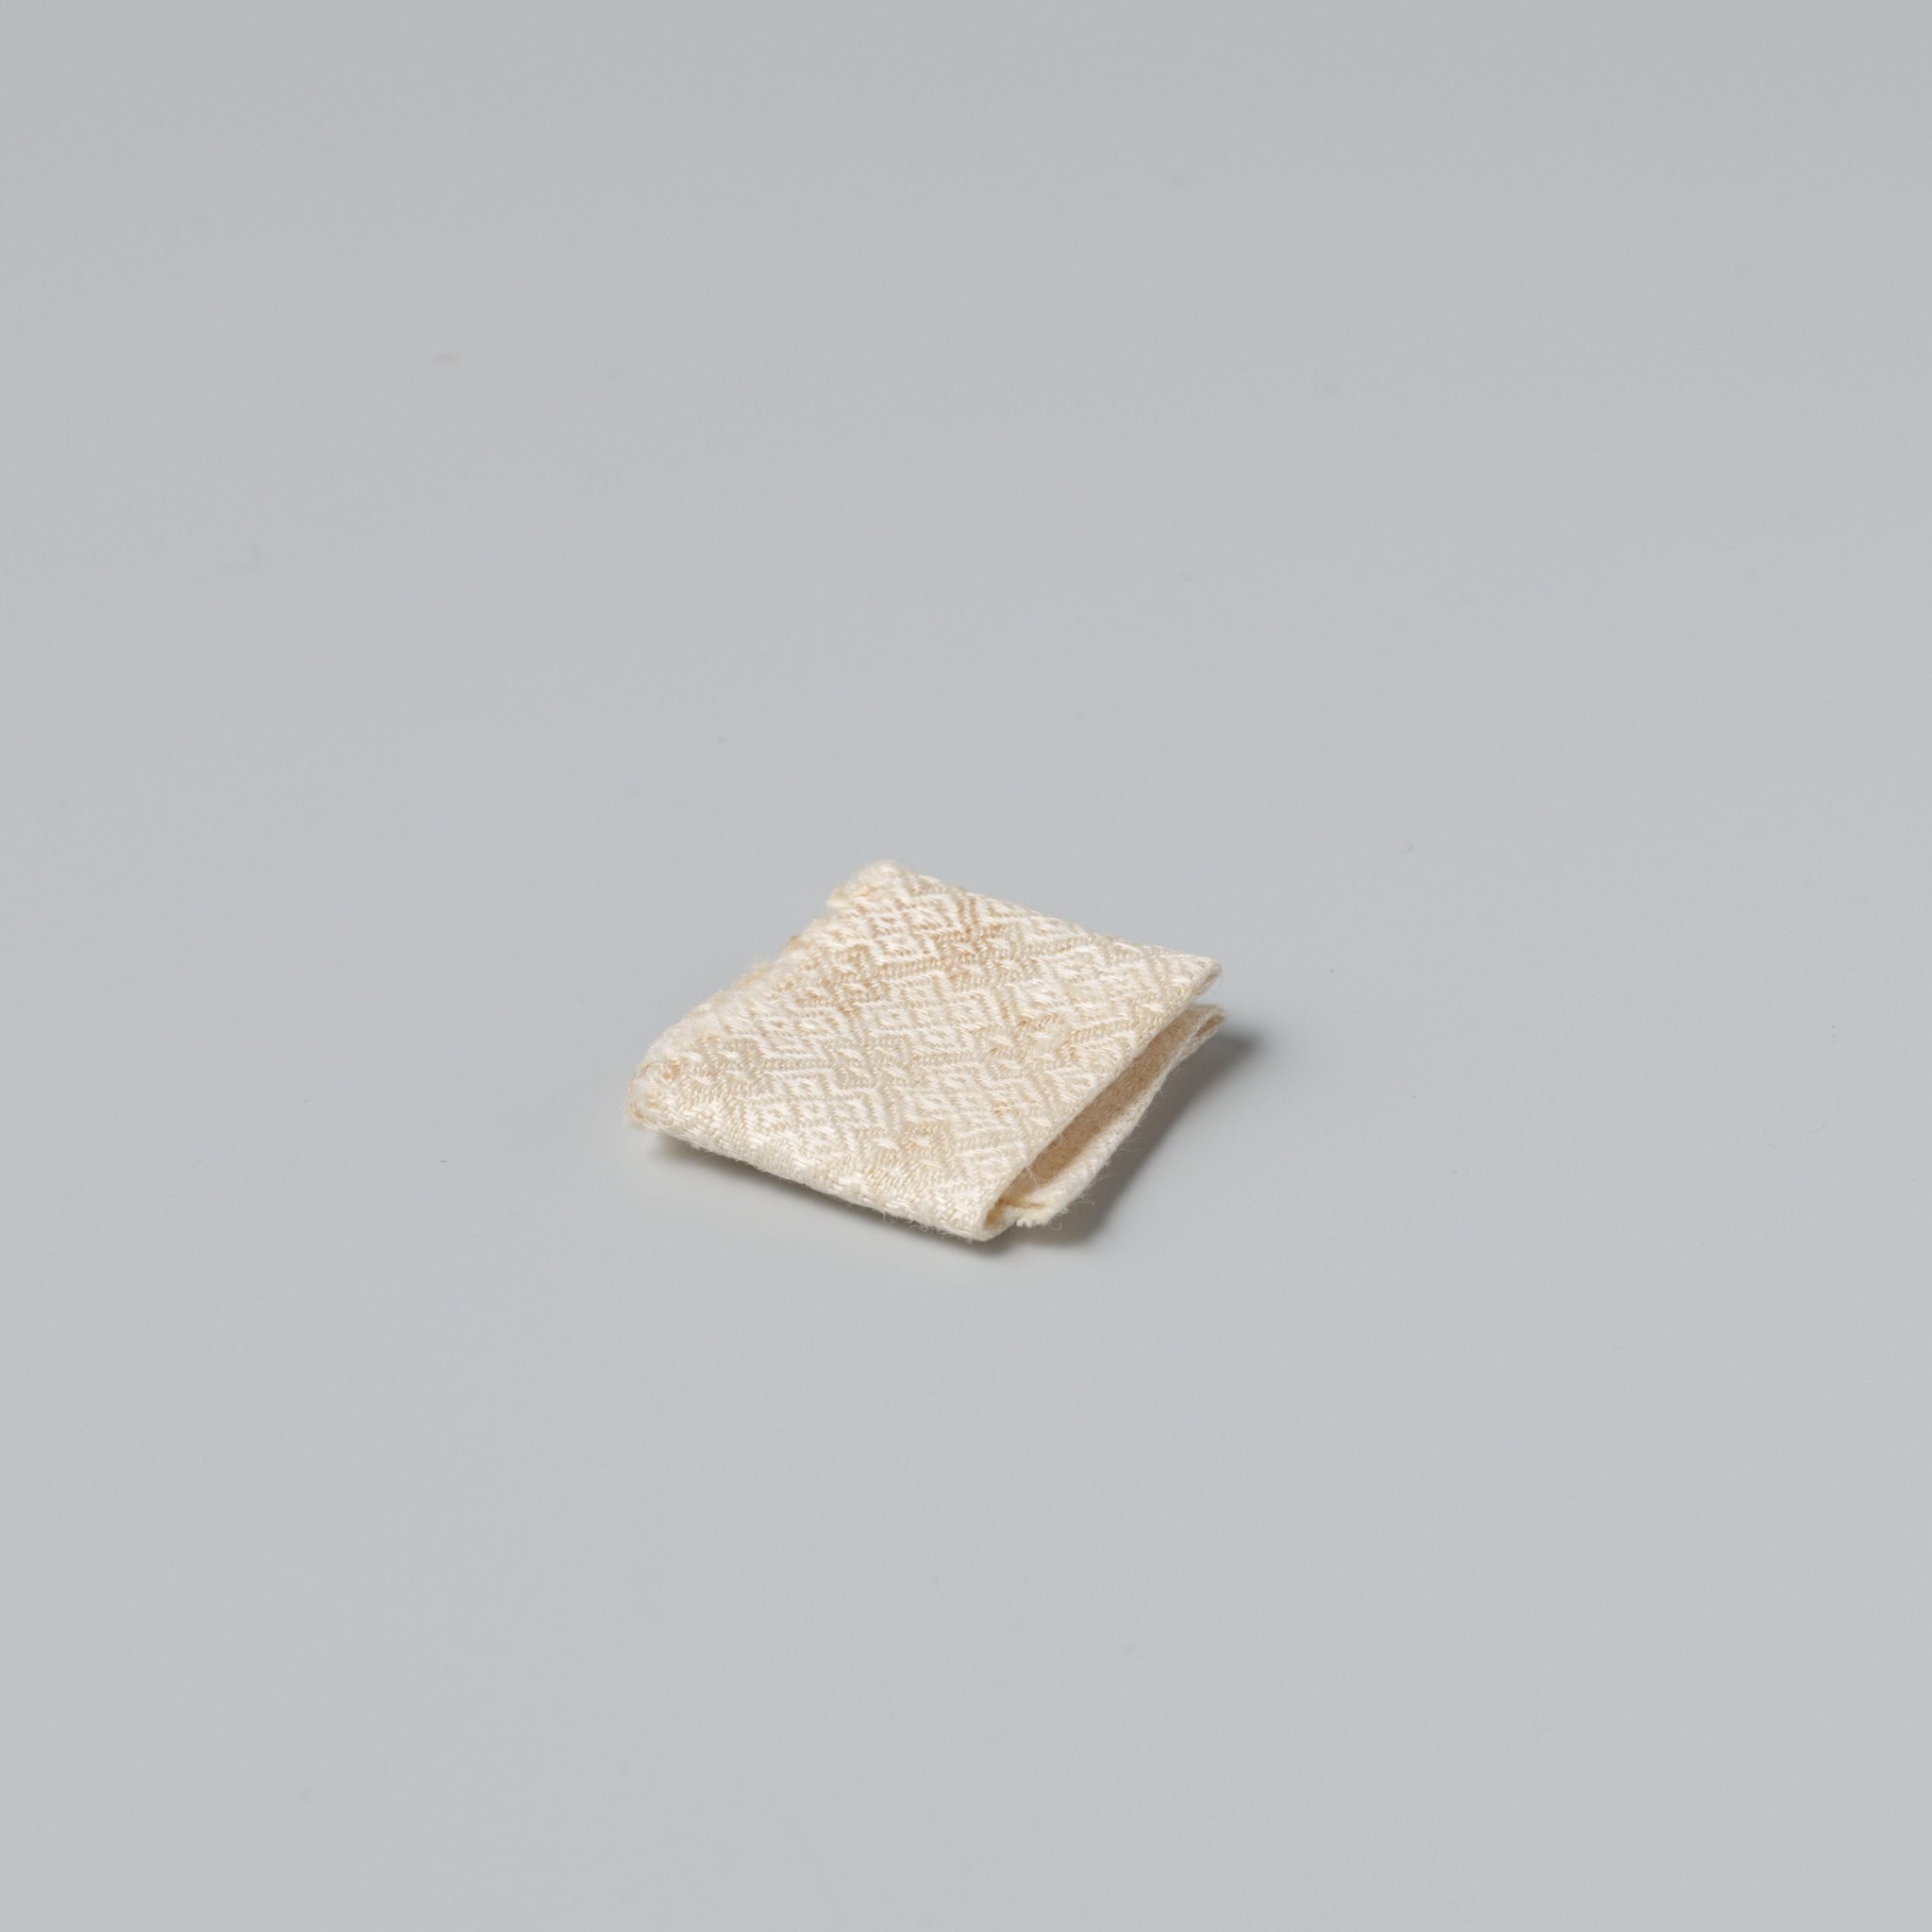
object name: miniature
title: Tafellaken, servet of handdoek van linnen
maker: Anonymous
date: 1600-1699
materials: linen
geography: netherlands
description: Tafellaken, servet of handdoek van linnen met een pellenpatroon, geknipt uit een groter stuk linnen. Geen zomen.